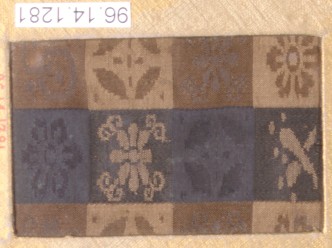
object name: piece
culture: japanese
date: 1701-1900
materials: silk